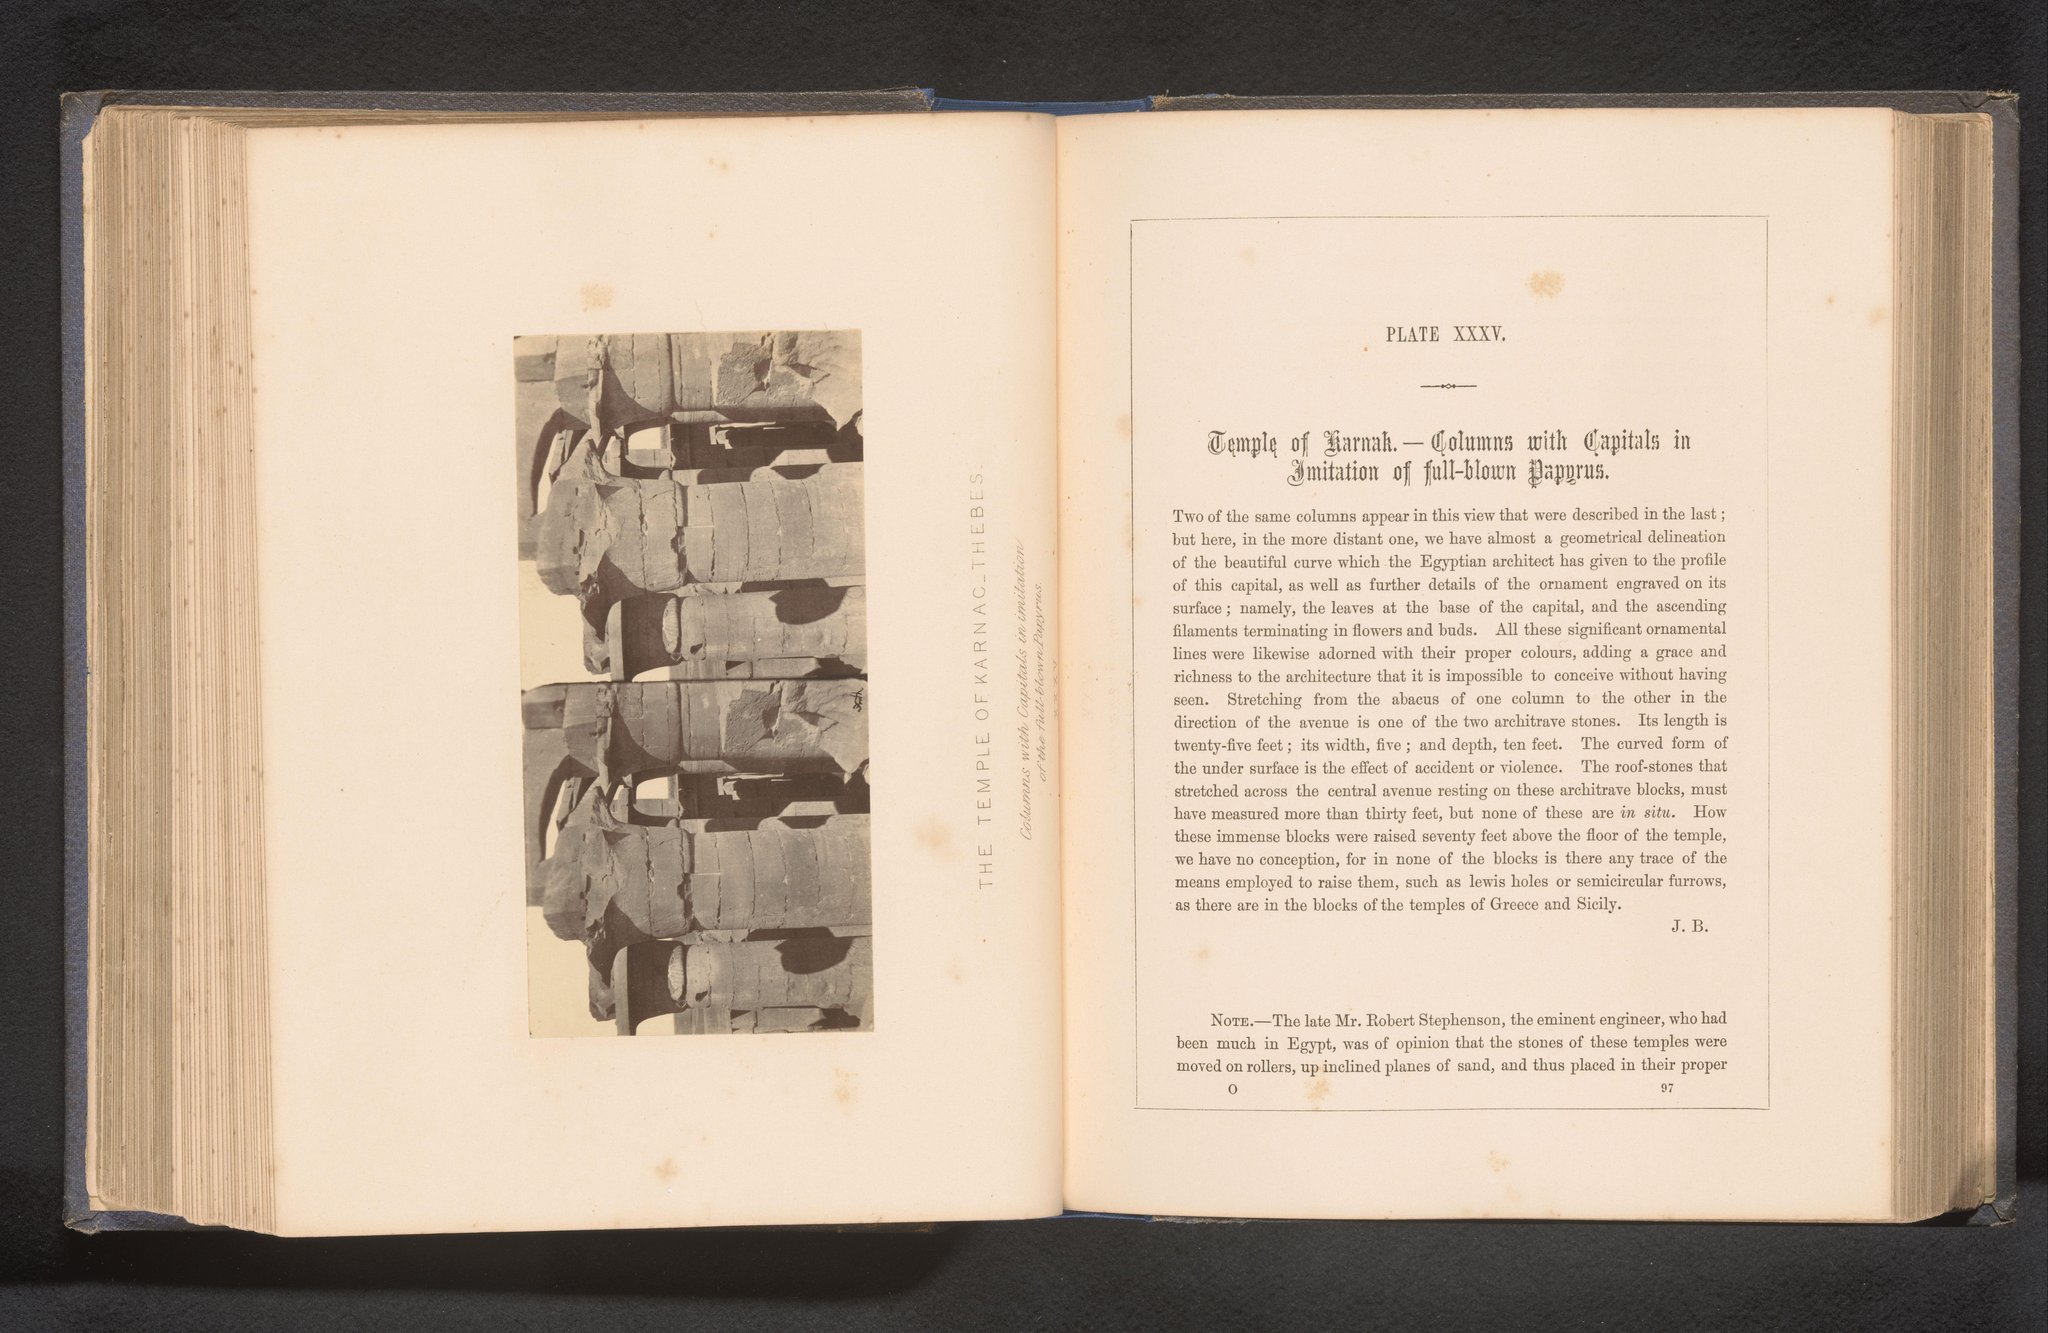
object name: stereograph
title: The temple of Karnak - Thebes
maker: francis frith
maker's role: publisher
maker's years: 1822-1898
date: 1857-1862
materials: photographic support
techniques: albumen print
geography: karnak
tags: column, pillar ~ architecture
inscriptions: inscription: ‘Columns with Capitals in imitation of the full-blown Papyrus’, name: ‘Frith’, number: ‘XXXV’